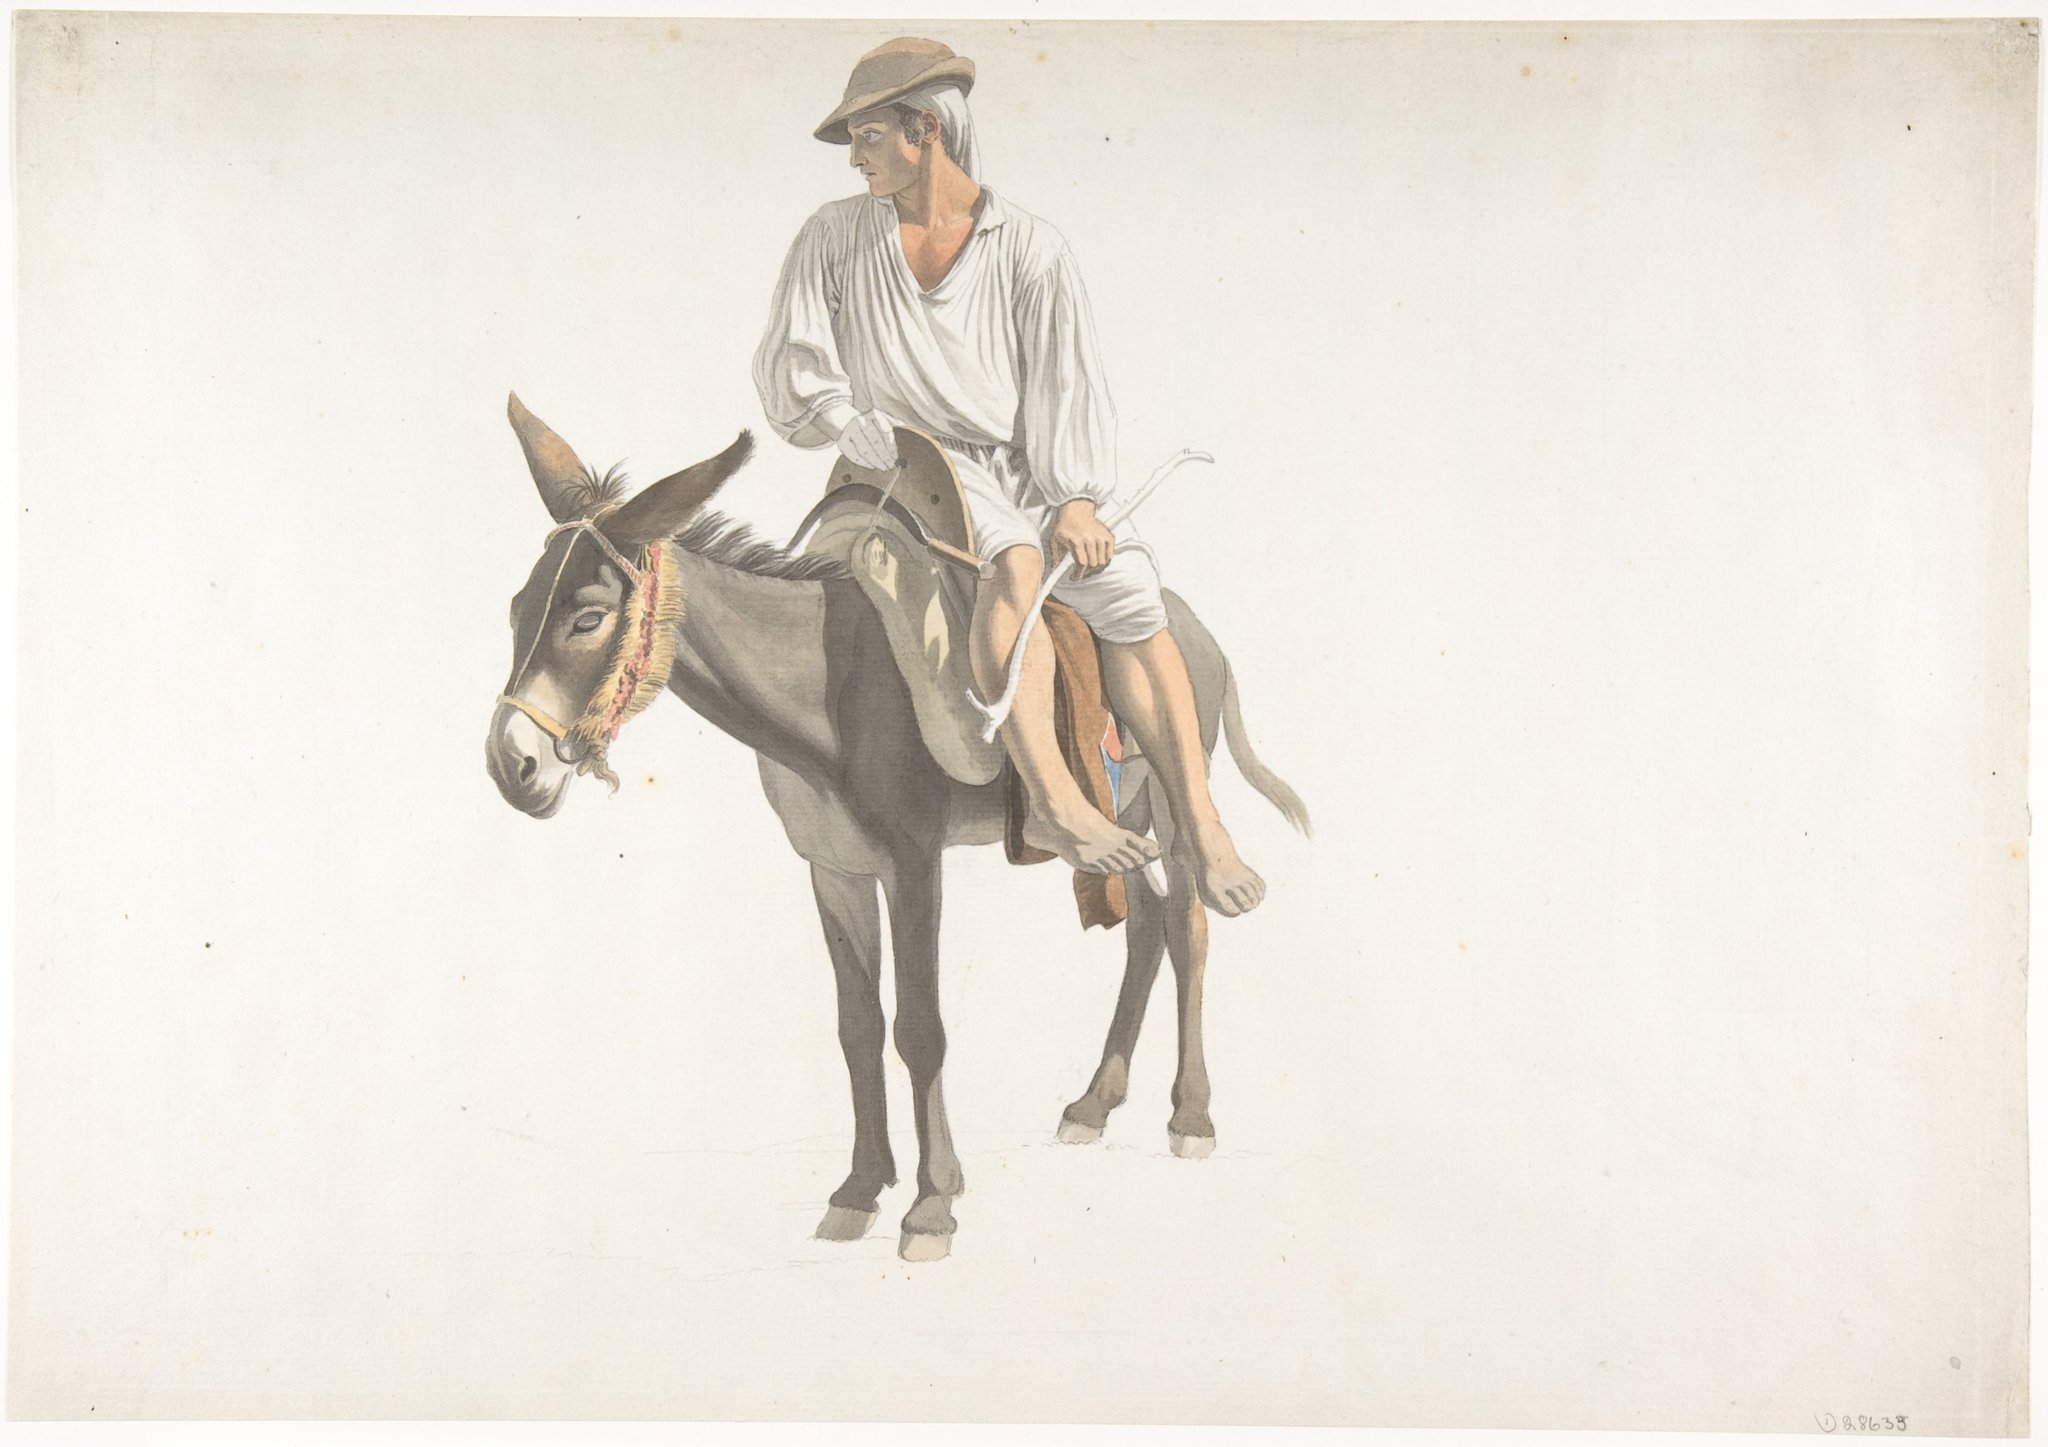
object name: drawing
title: Peasant on a Donkey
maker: giovanni battista ("titta") lusieri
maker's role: artist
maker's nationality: italian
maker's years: 1754-1821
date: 1783-1787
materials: graphite, watercolor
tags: men,donkeys